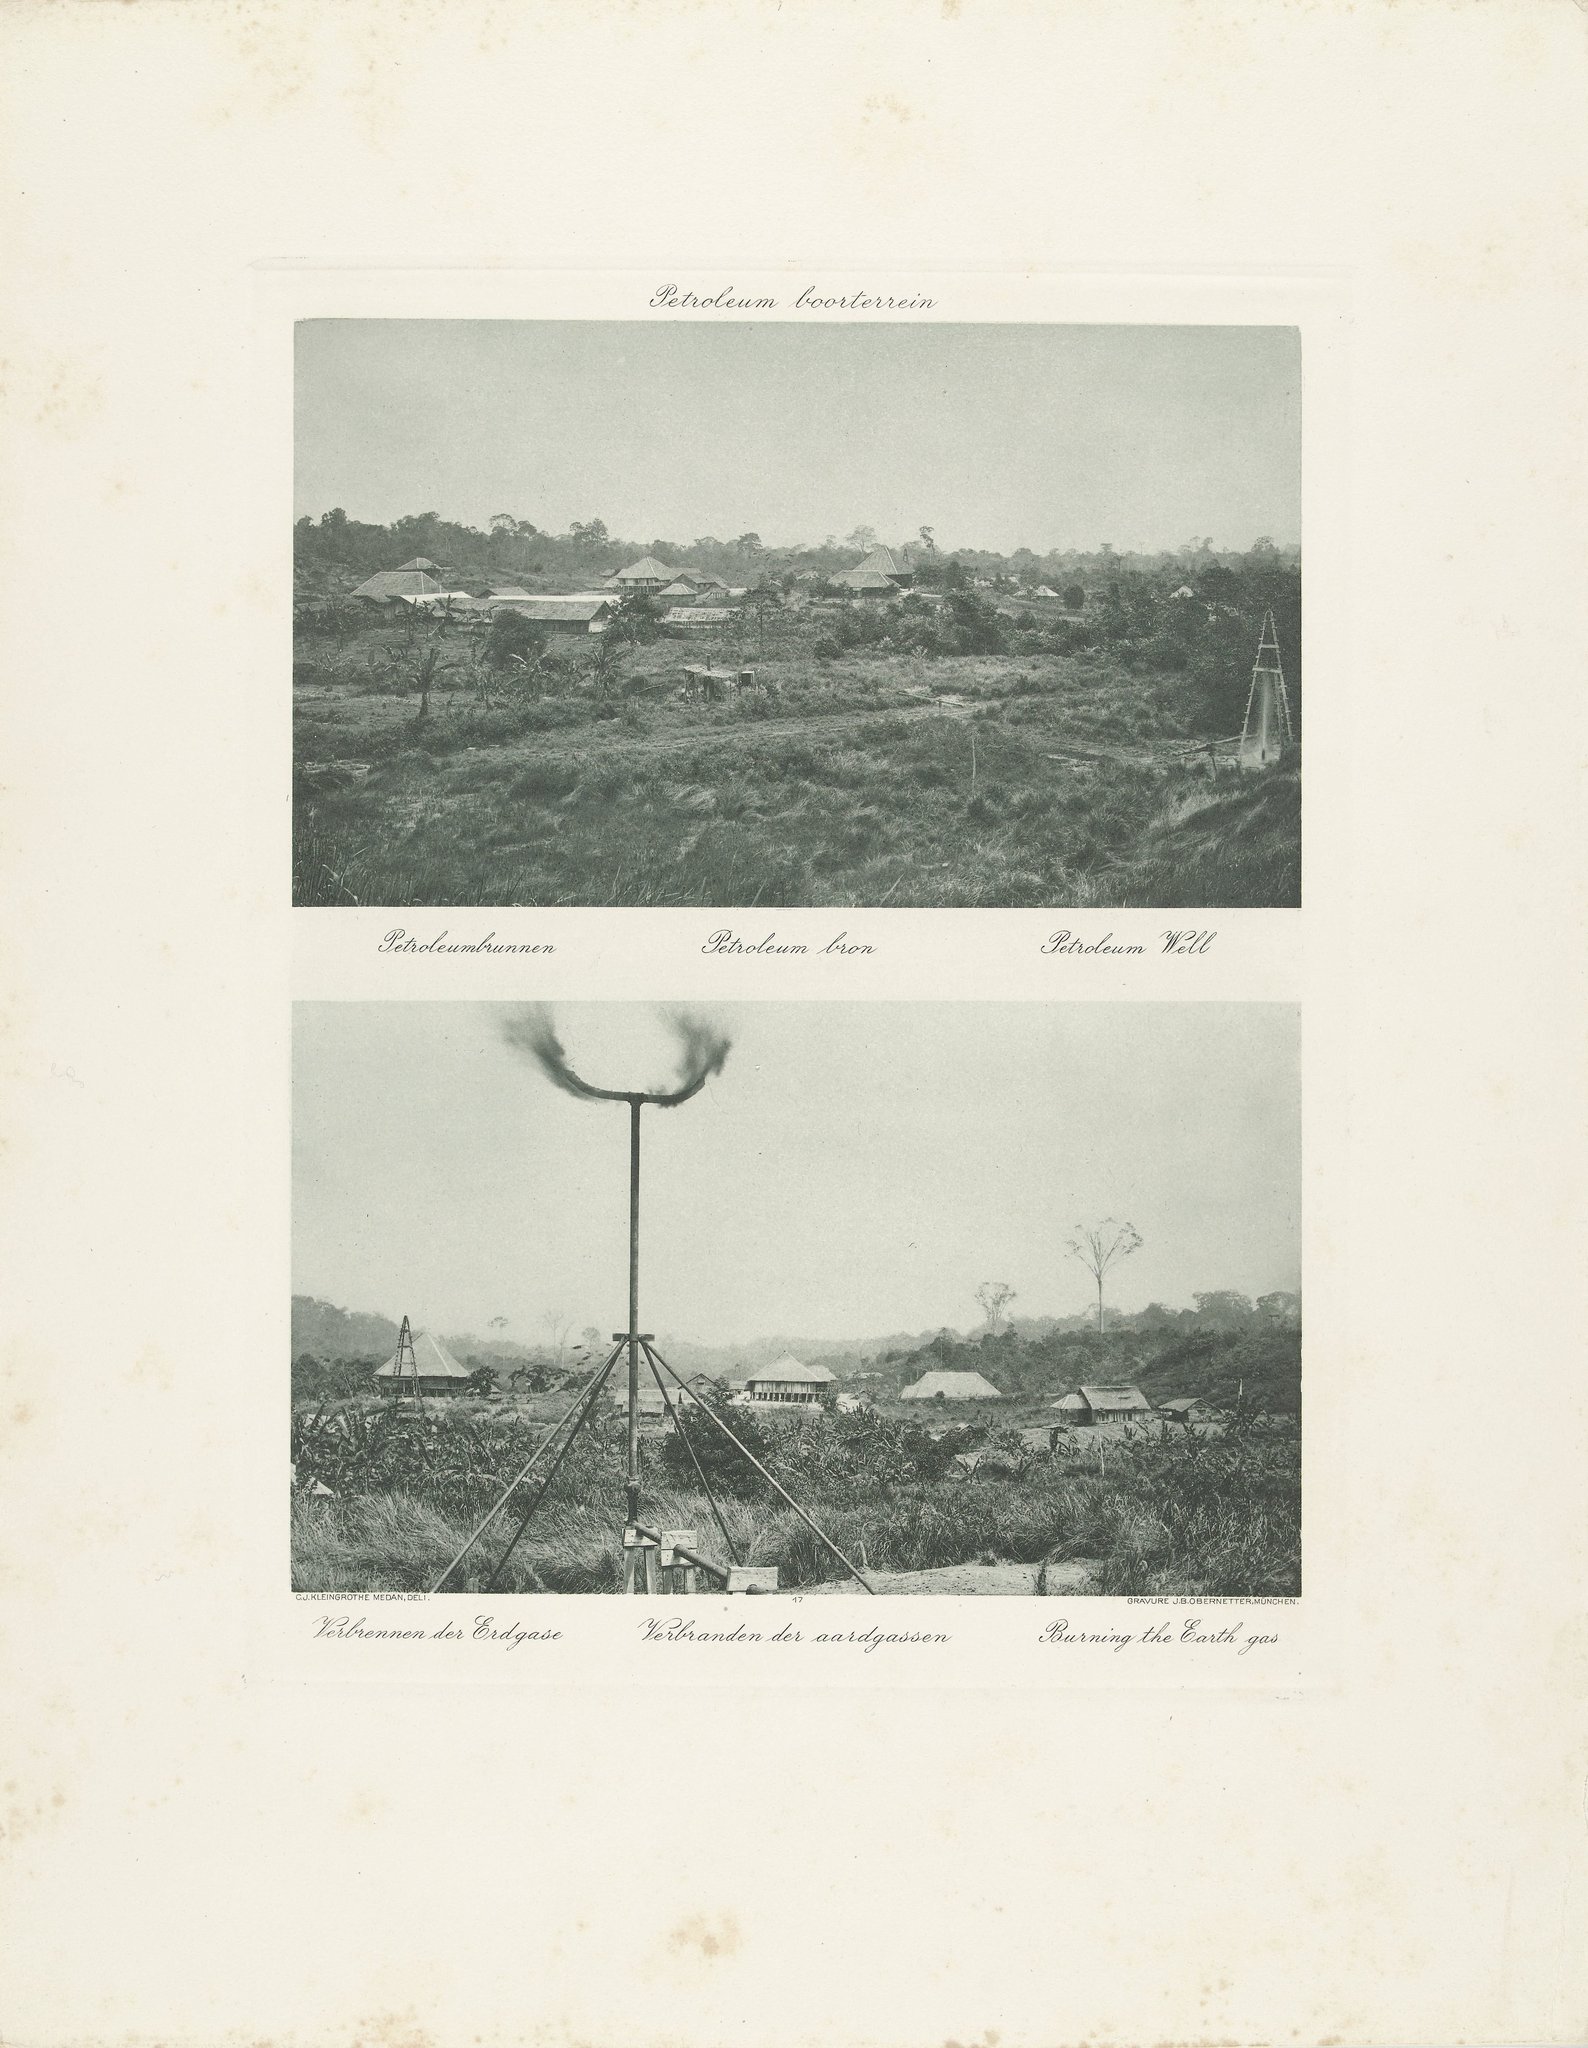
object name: album leaf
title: Olieveld op Sumatra: bron (boven) en gasfakkel (onder)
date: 1883-1887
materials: paper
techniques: photoaquatint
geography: munich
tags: oil; oil refinery, pumping of oil, sumatra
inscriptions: number: ‘17’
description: Onderdeel van Album met heliogravures van Sumatra's oostkust.